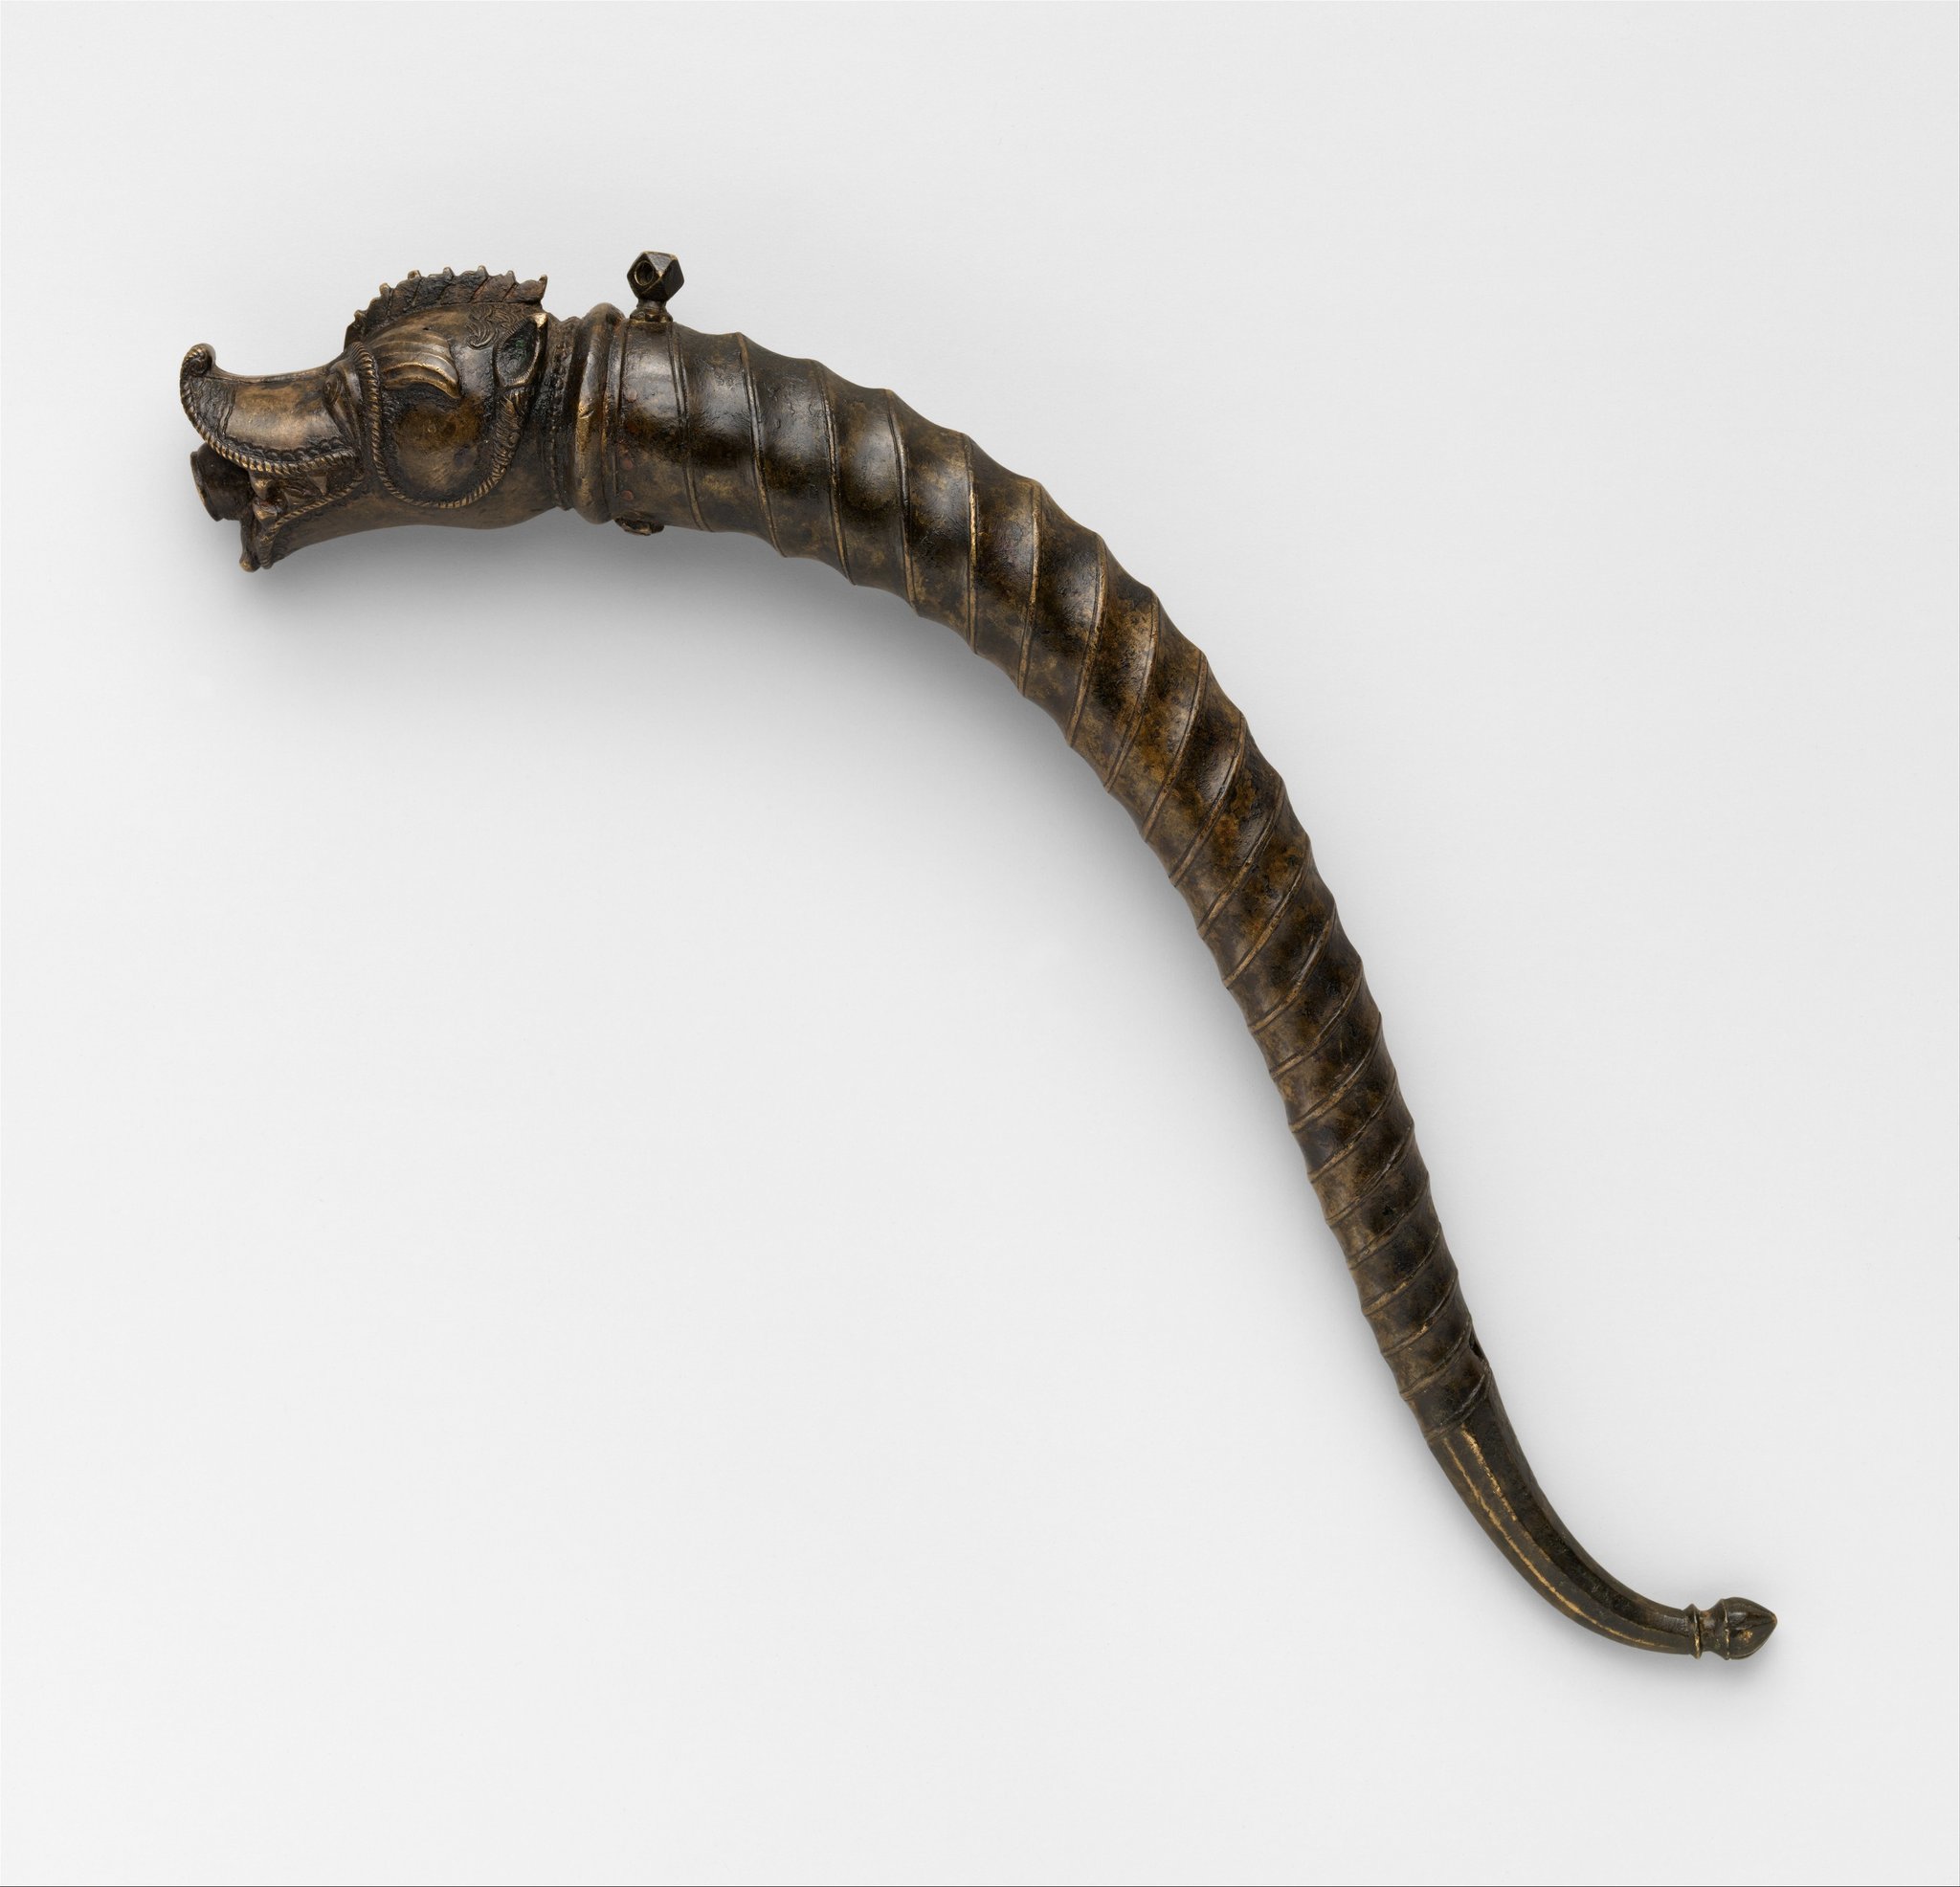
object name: primer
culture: indian, rajasthani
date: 1701-1800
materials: brass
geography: india